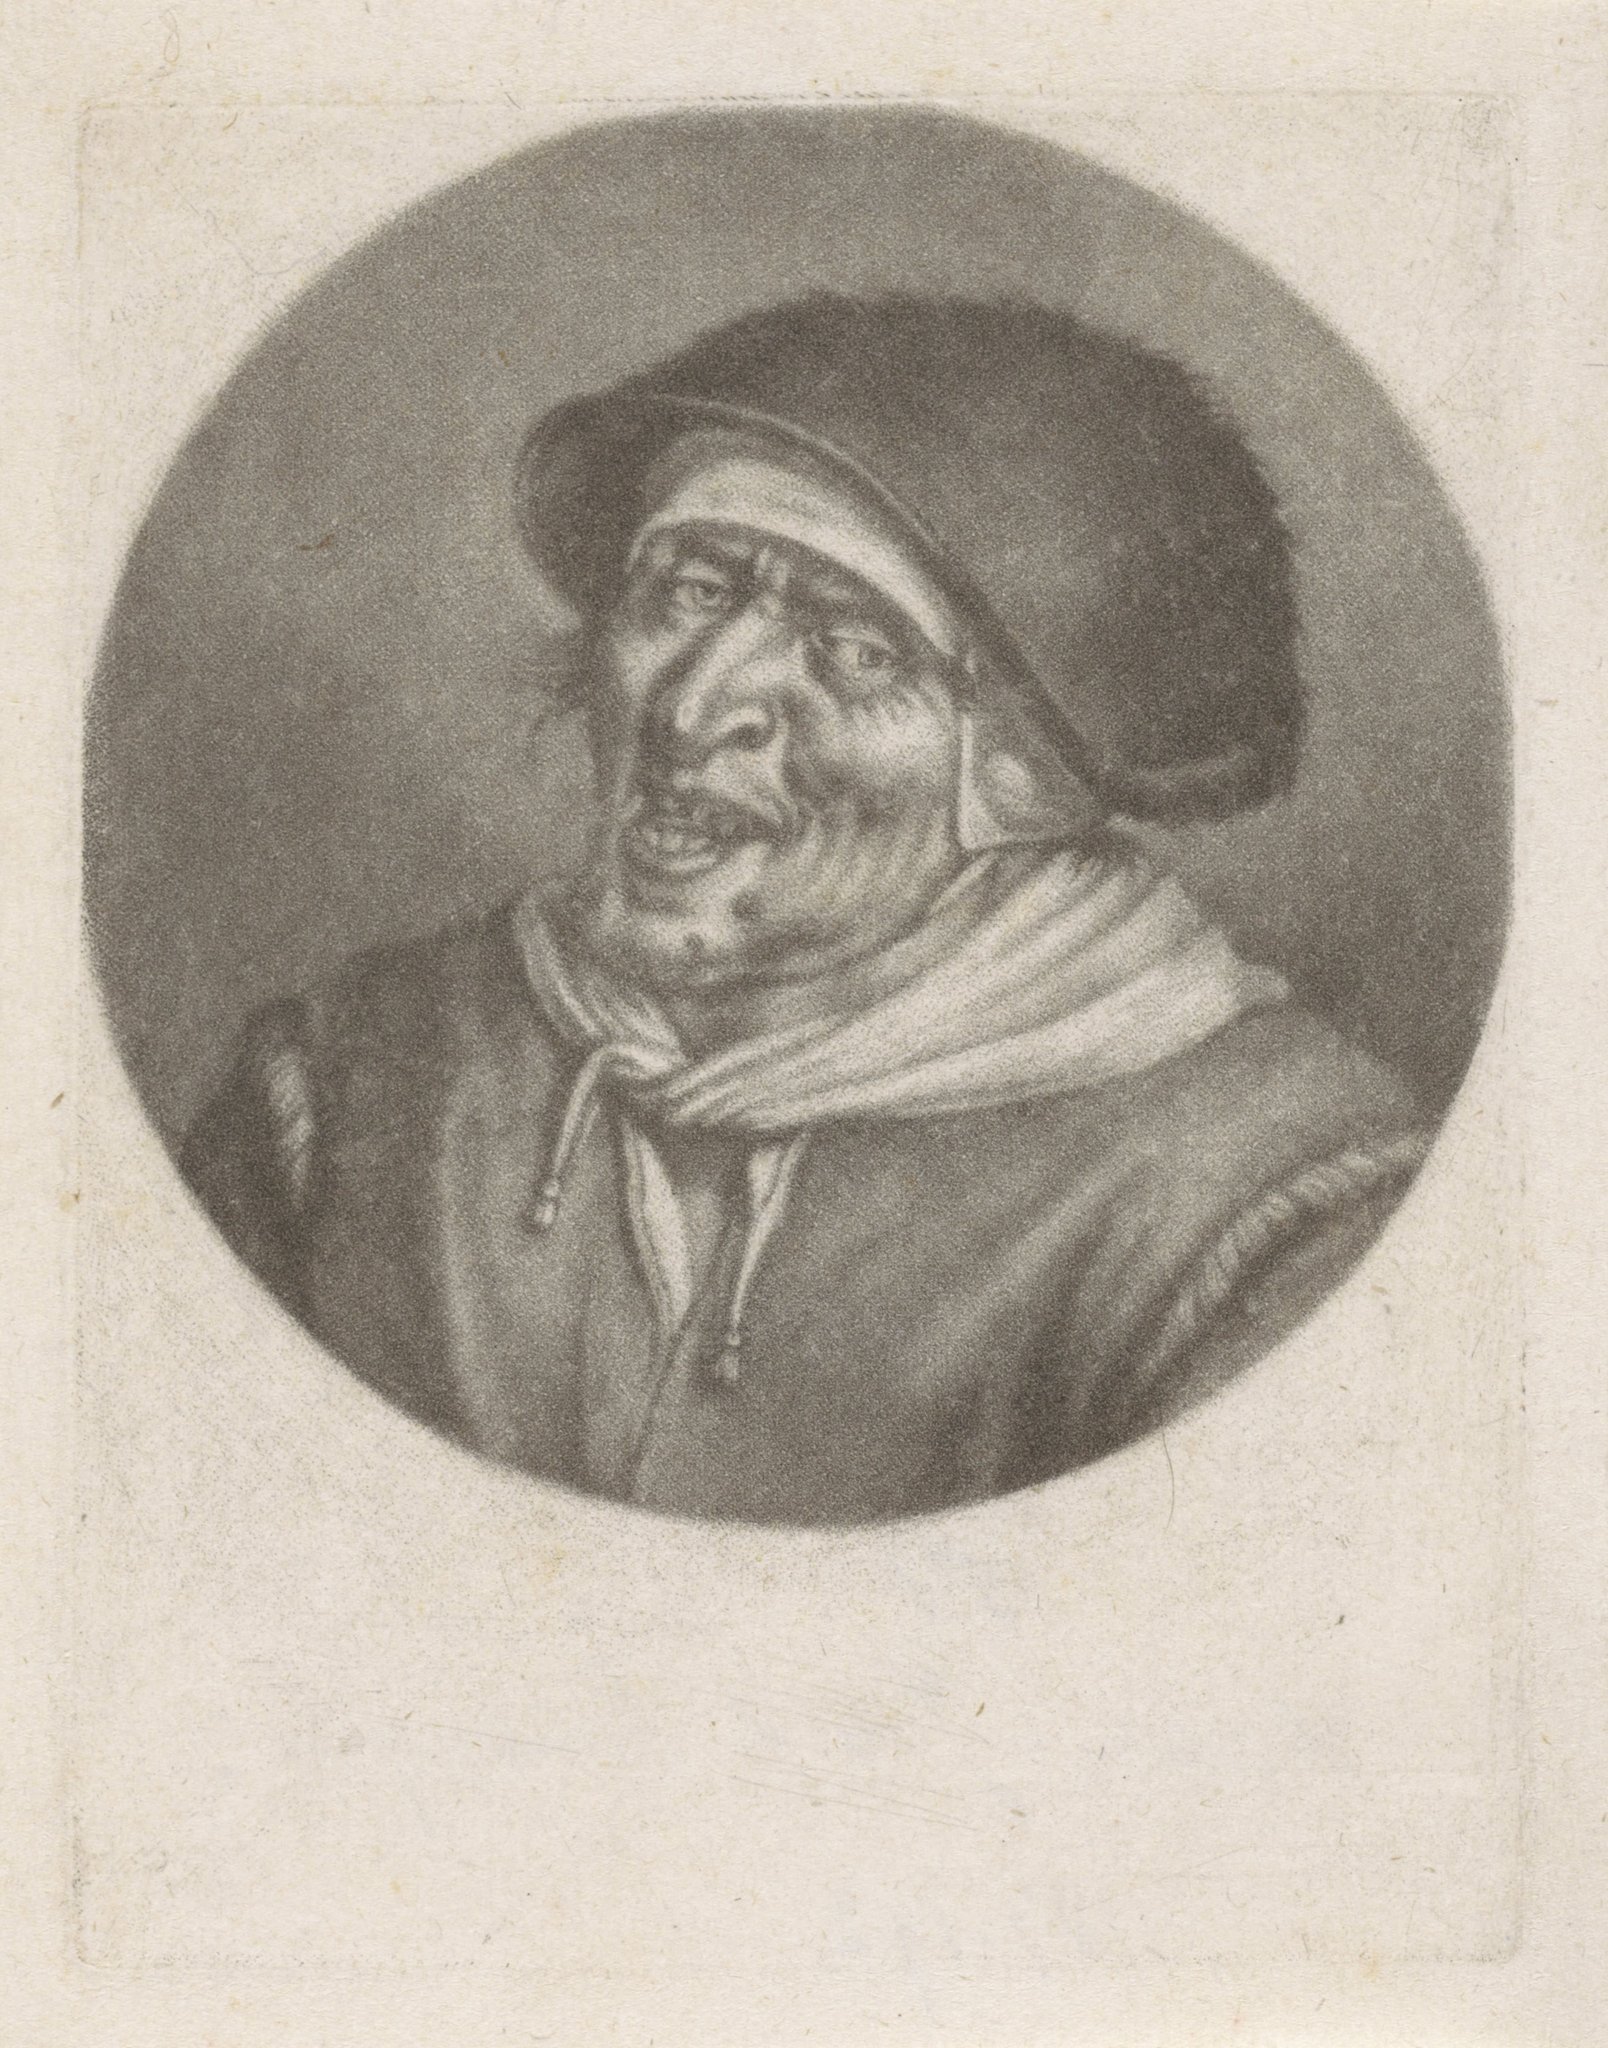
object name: print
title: Kop van een zingende man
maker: Anonymous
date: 1650-1800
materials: paper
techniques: mezzotint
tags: vocal music, singing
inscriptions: collector's mark: Lugt 2228